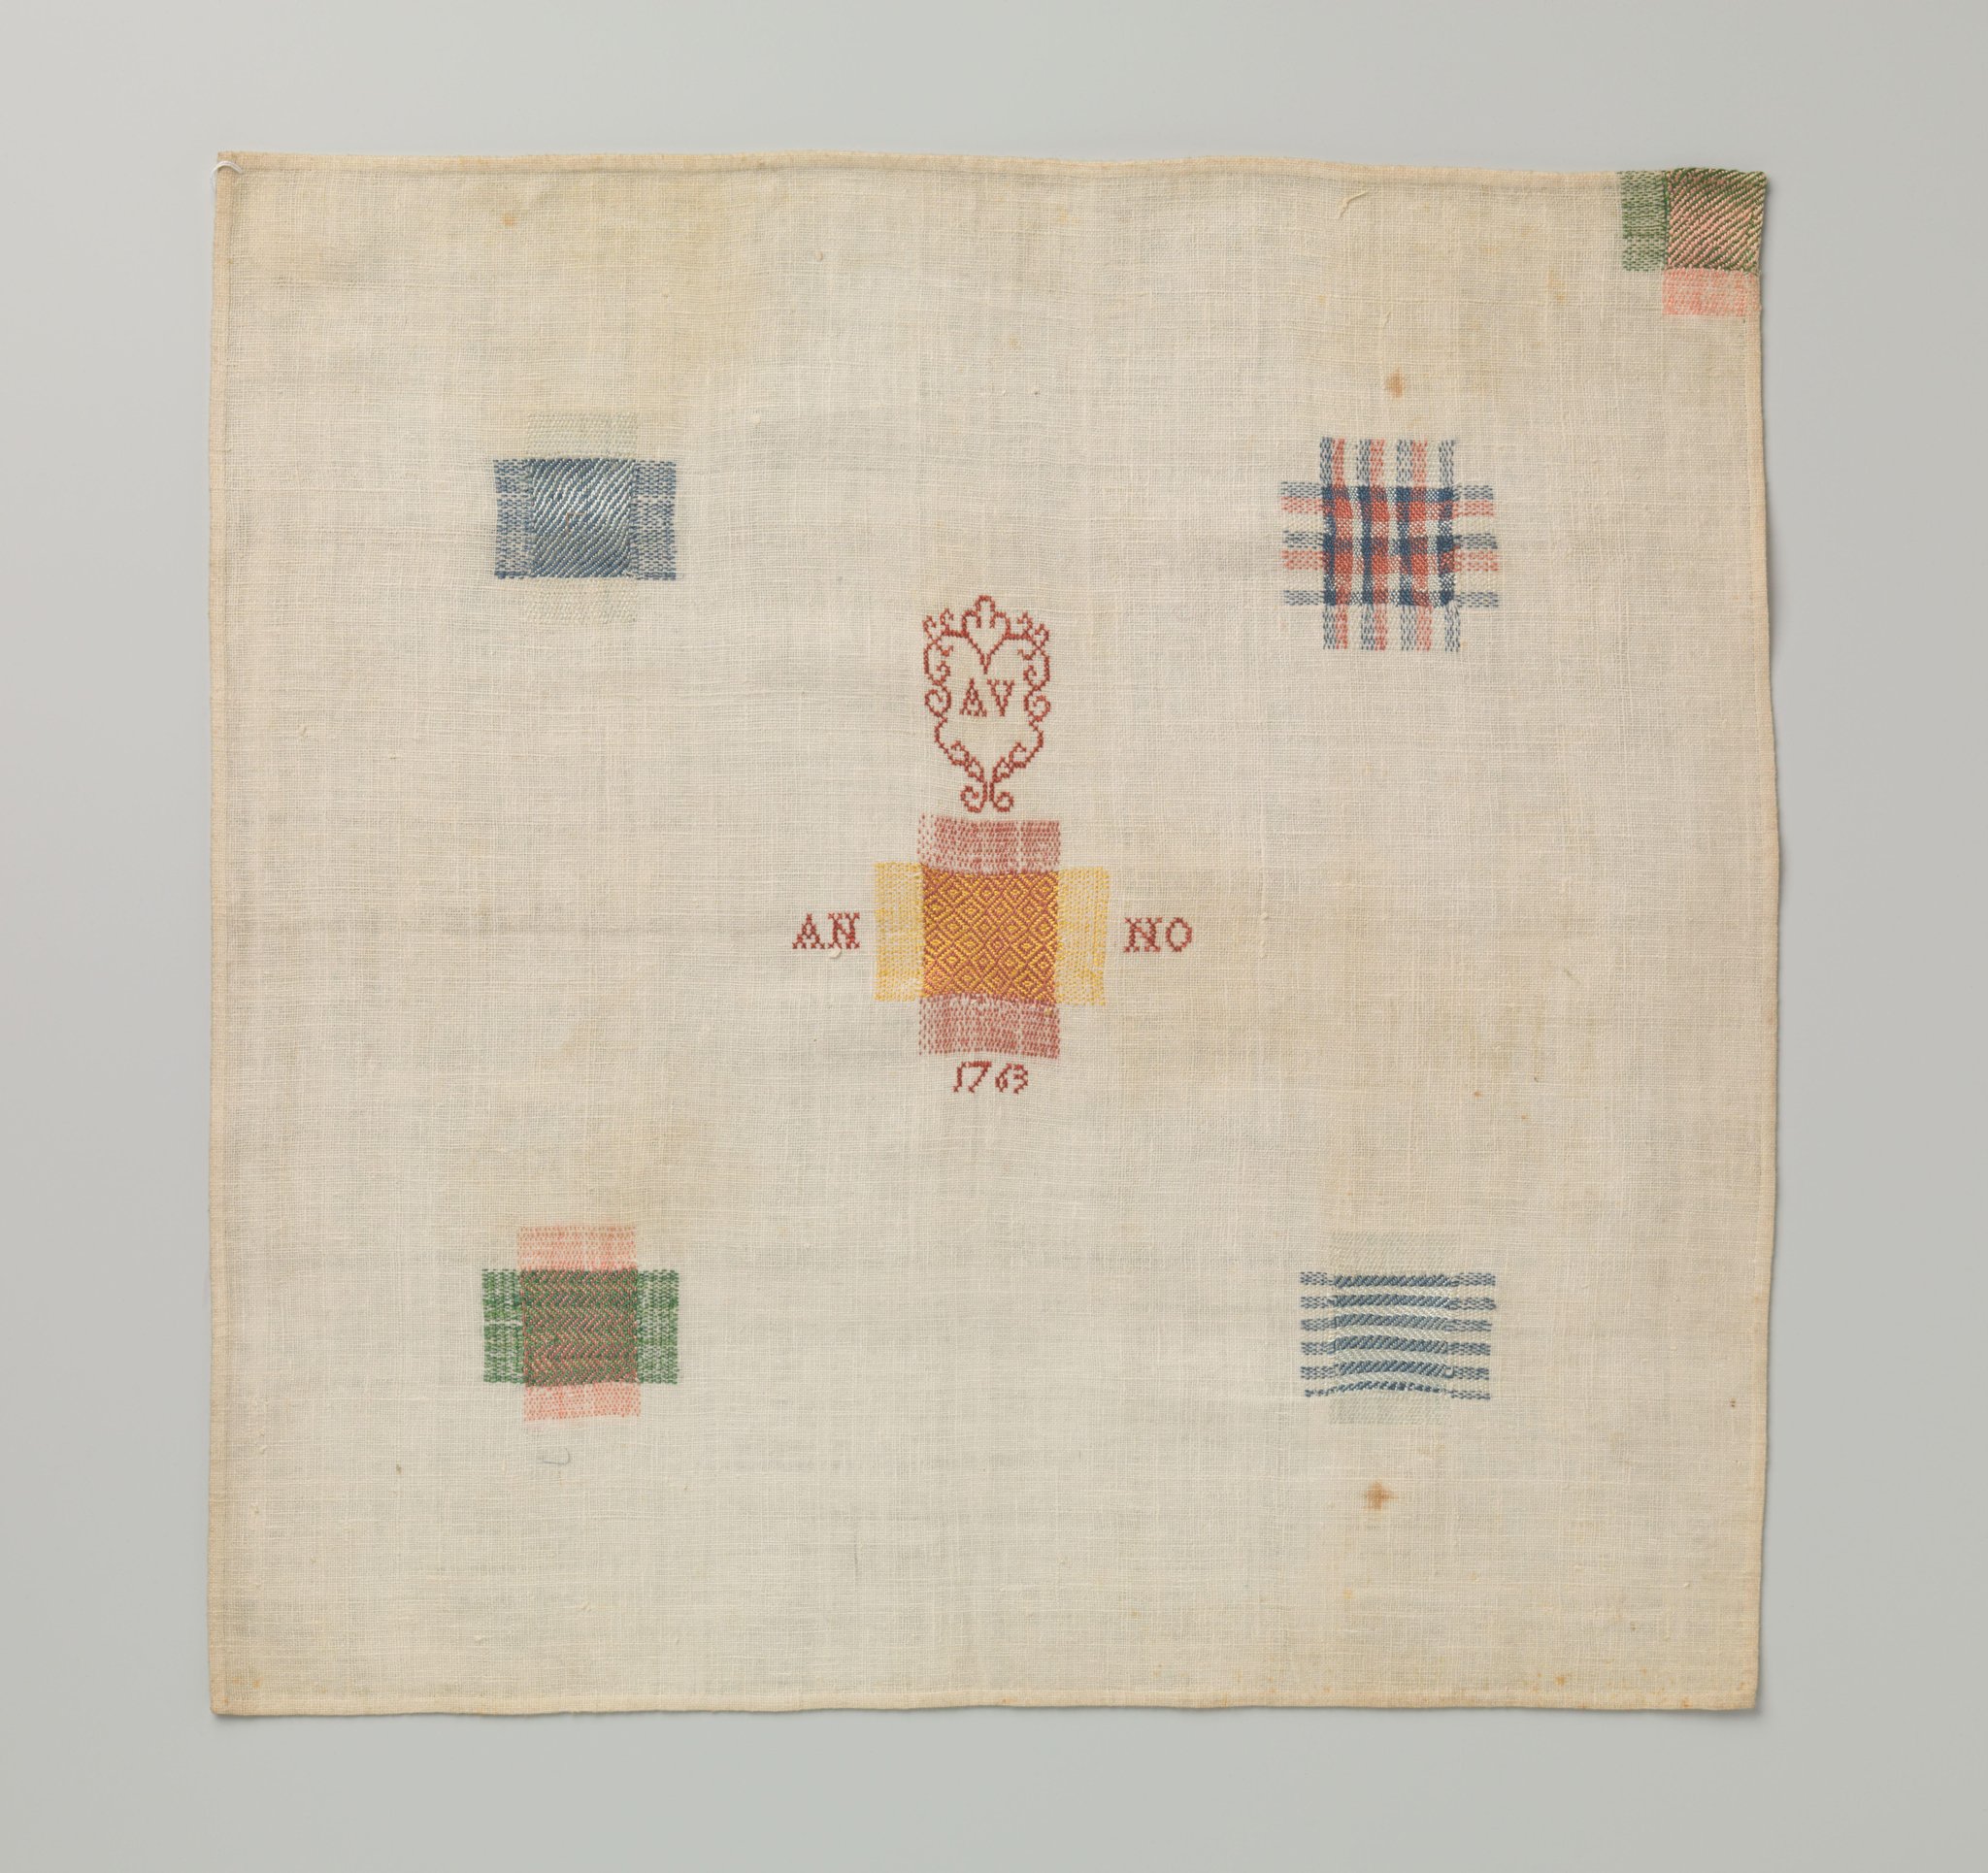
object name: stoplap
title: Stoplap van veelkleurige zijde op katoenen mousseline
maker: Anonymous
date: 1763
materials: cotton, silk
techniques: embroidered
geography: leiden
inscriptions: date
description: Stoplap van zijde op katoen. Het borduurwerk heeft de initialen AV en de datering ANNO 1763.